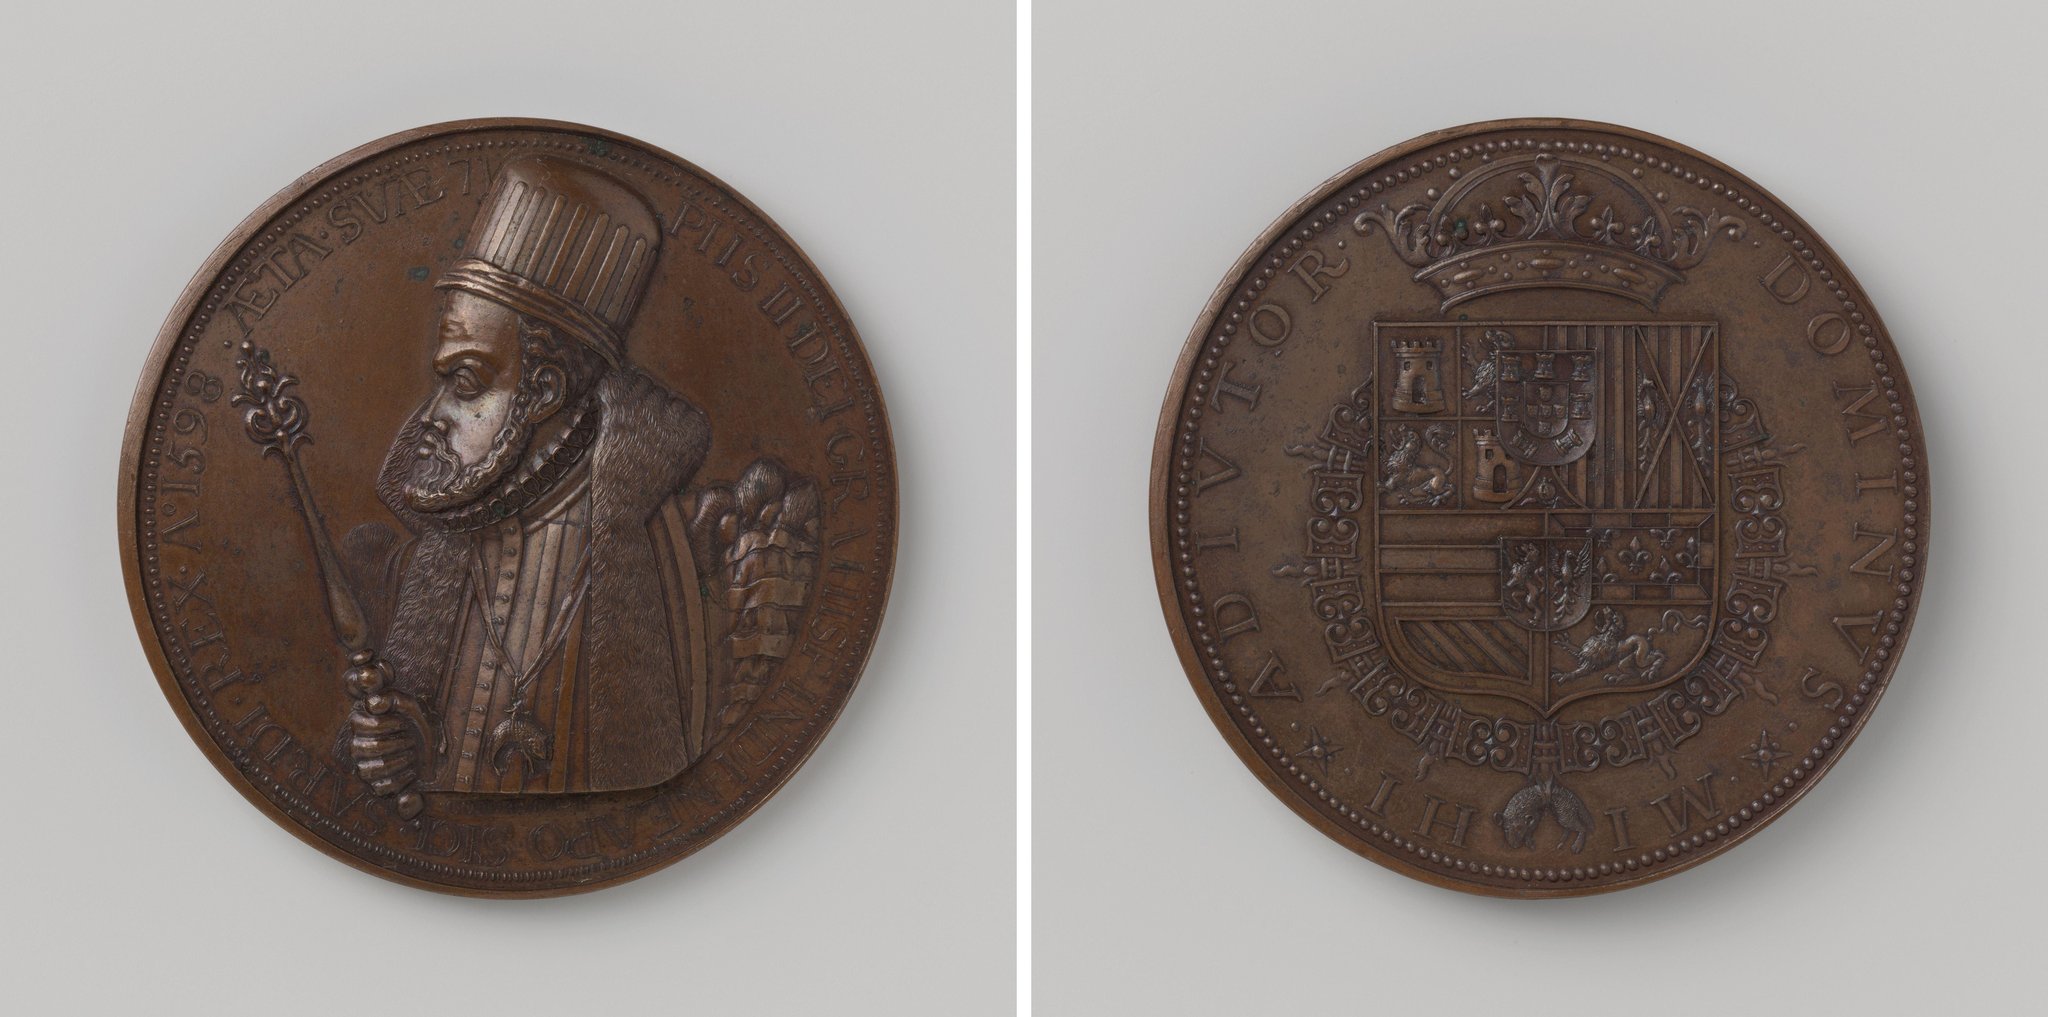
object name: copy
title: Philips II, koning van Spanje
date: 1598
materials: bronze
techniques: casting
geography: flanders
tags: philip ii of spain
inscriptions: circumscription: ‘PHS II DEI GRA HISP INDI NEAPO SICI SARDI REX Ao 1598 AETA SVAE 71’, circumscription: ‘DOMINVS MIHI ADIVTOR’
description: Bronzen penning. Voorzijde: borststuk man met hoed en scepter binnen omschrift. Keerzijde: gekroond wapenschild omhangen met orde van Gulden Vlies binnen omschrift.